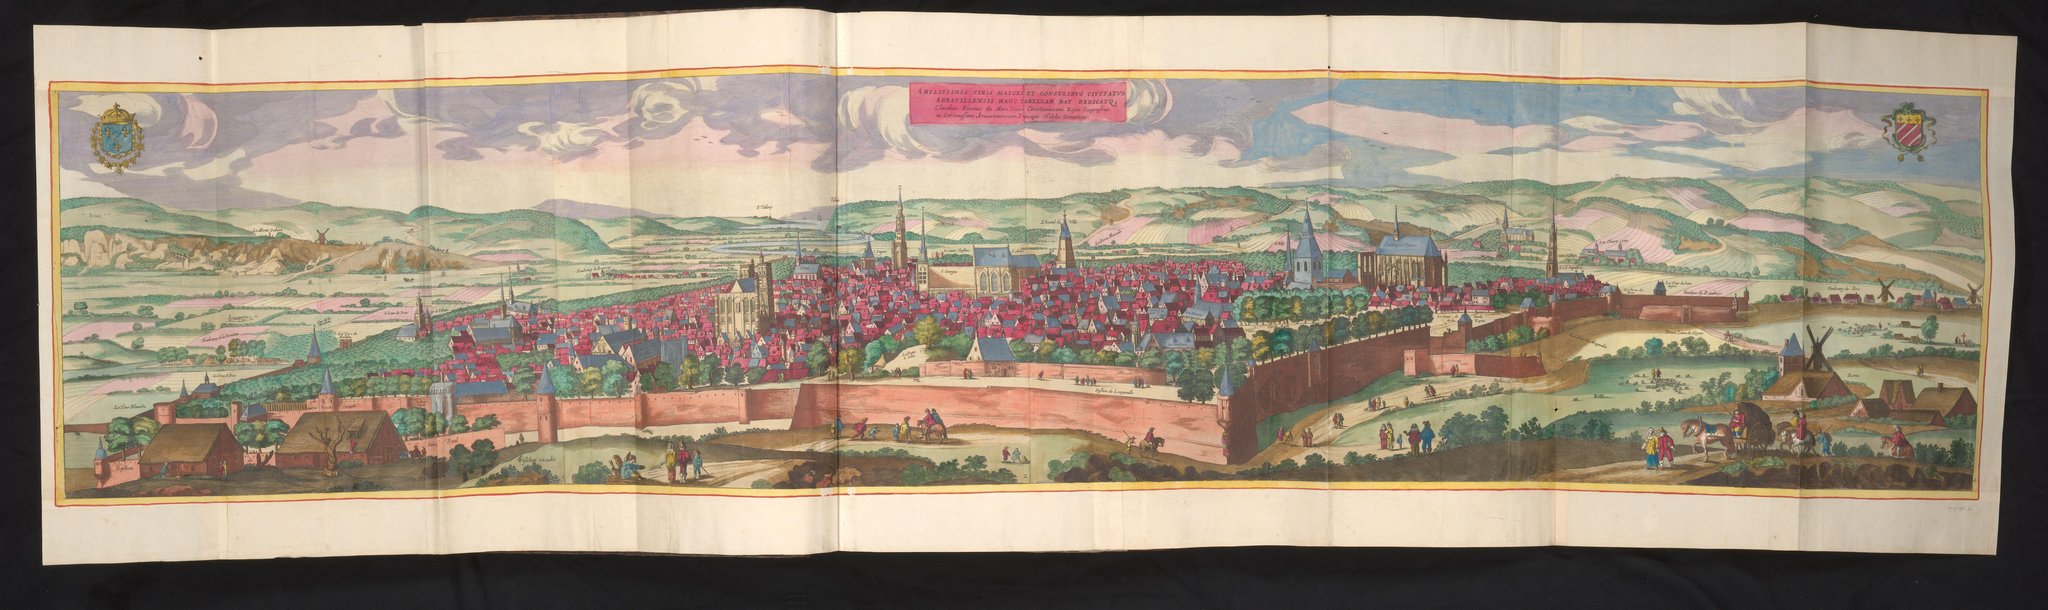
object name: album leaf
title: Panorama van Abbeville in vogelvluchtperspectief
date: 1596-1652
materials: paper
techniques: engraving, hand coloring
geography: the hague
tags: city-view in general; 'veduta'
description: Deze prent maakt deel uit van een album.